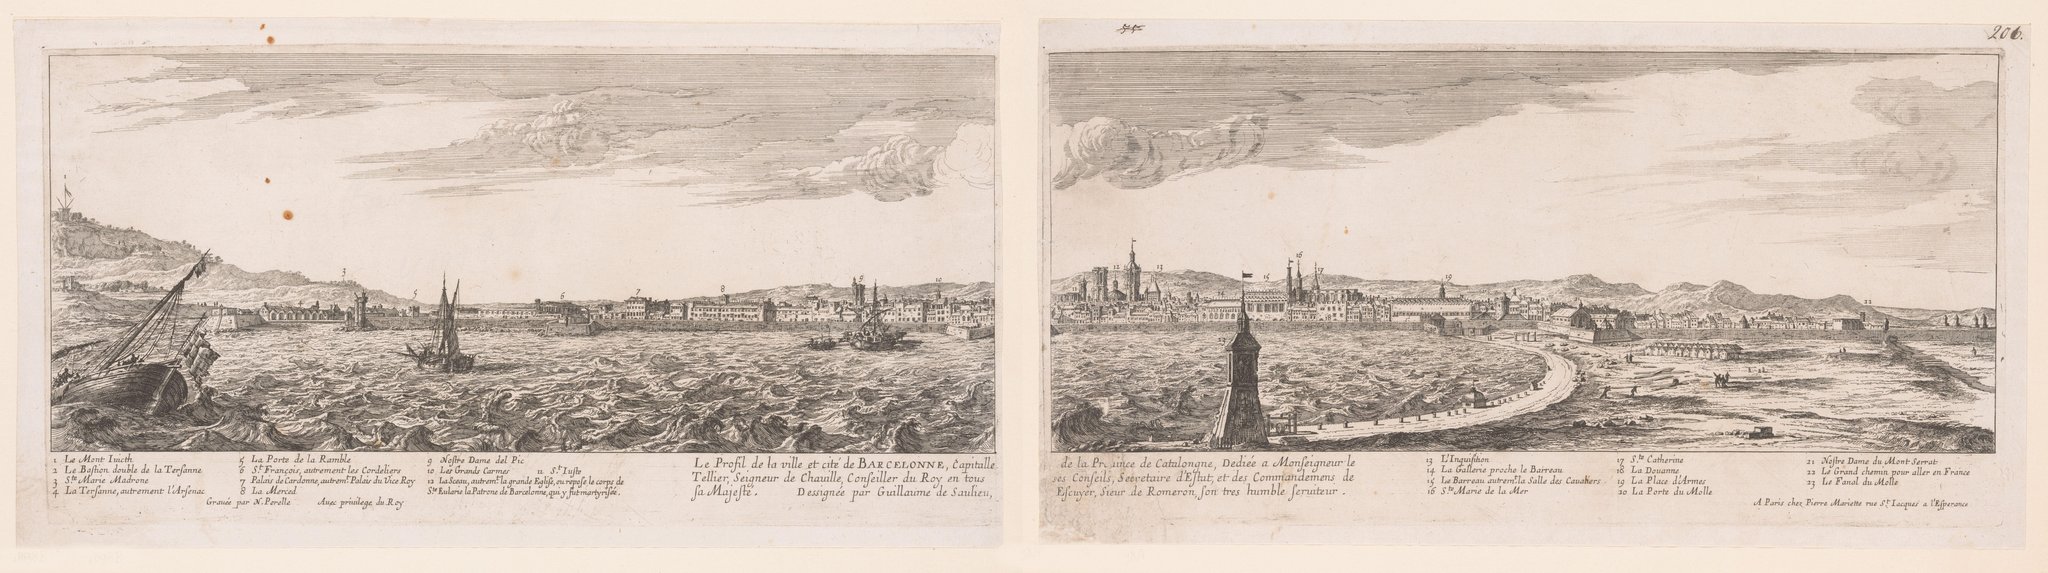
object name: print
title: Gezicht op Barcelona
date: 1641-1695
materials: paper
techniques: engraving, etching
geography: france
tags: city-view in general; 'veduta'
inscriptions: number: ‘206’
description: Dit object is omwille van een betere presentatie virtueel samengevoegd, maar bestaat fysiek uit losse onderdelen.